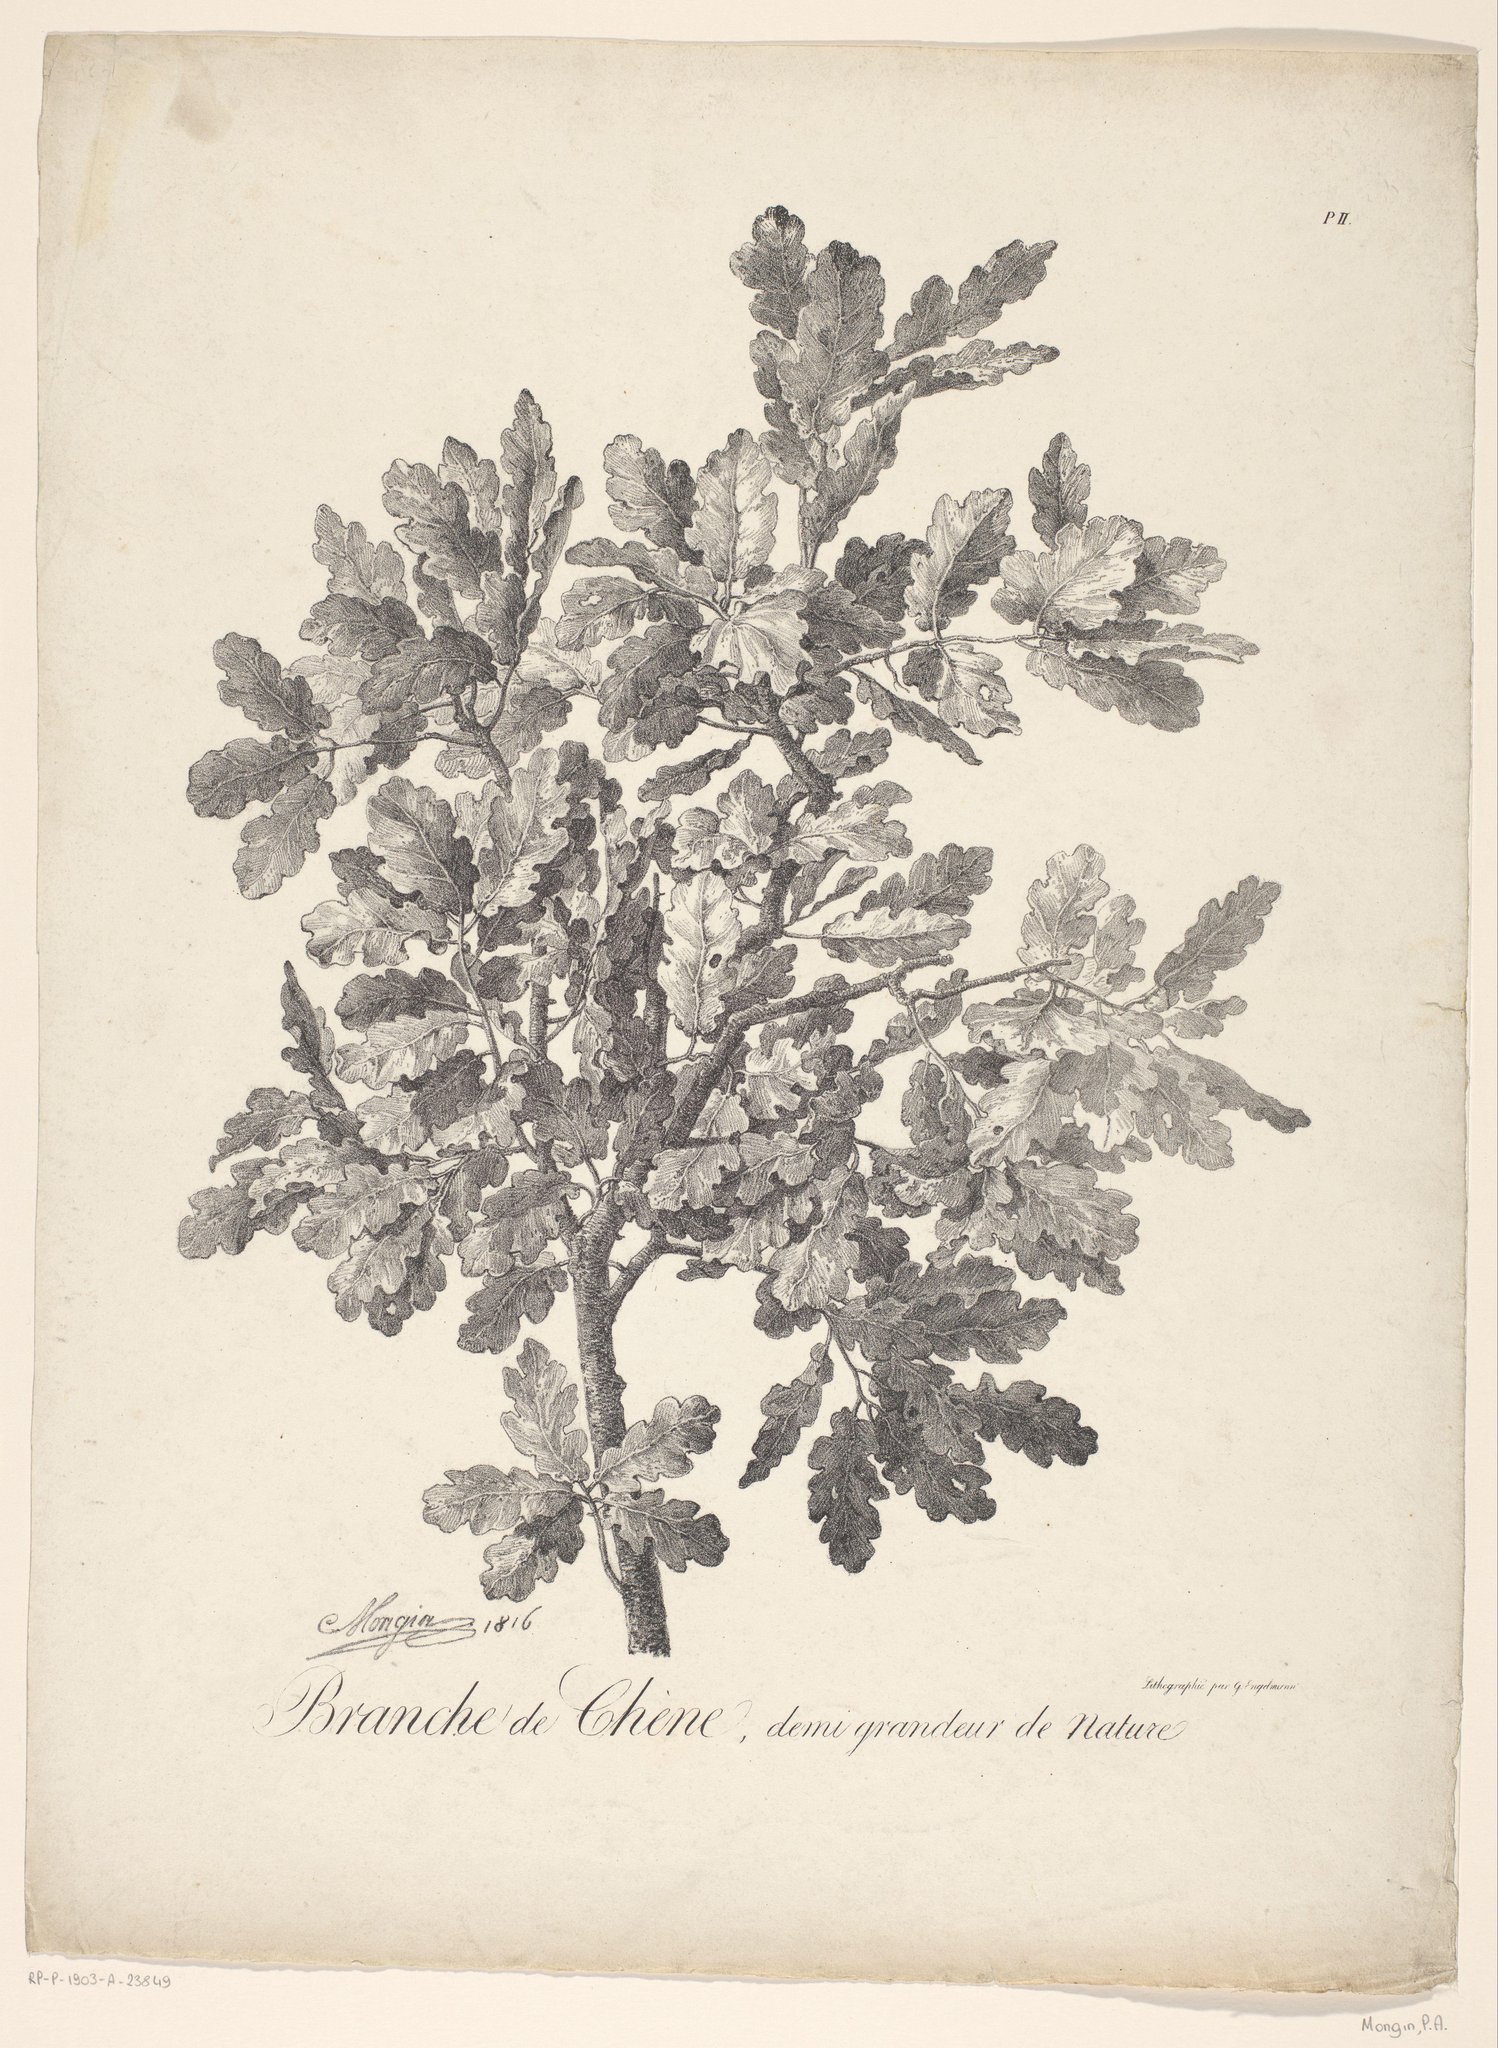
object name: print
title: Studie van een tak met eikenbladeren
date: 1816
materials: paper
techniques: lithograph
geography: paris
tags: trees: oak (+ branch, stick)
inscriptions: collector's mark: Lugt 2228